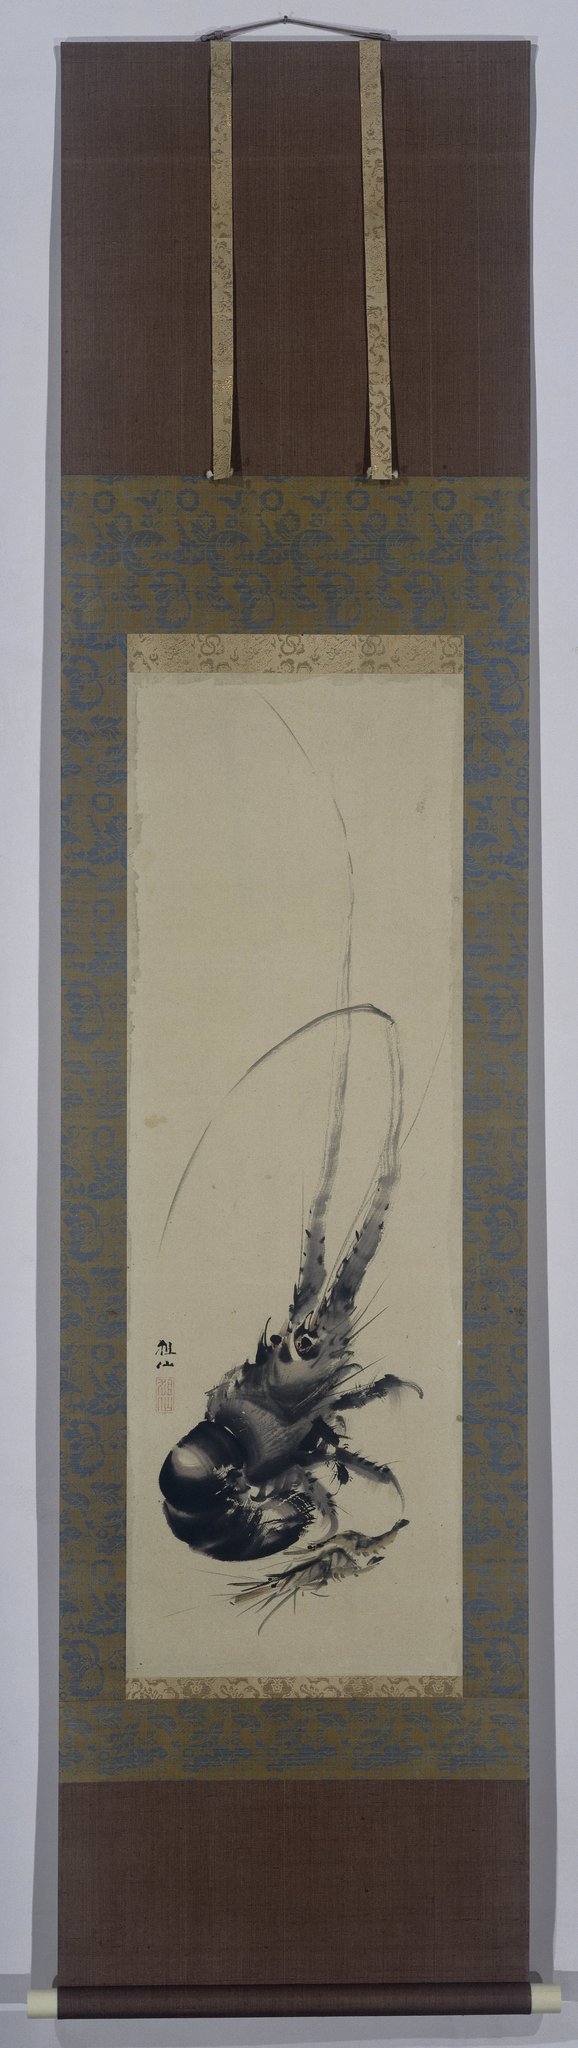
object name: hanging scroll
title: Langoustines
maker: mori sosen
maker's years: 1747-1821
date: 1800-1825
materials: ink, paper, silk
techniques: painted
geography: japan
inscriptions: seal: ‘Sosen’, signature: ‘Sosen’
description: Working from nature came first for Sosen. He made countless sketches to perfect his skills in rendering the animals as naturalistically as possible, both their appearance and their character. He depicted the langoustines with virtuoso strokes of ink, using subtle grey and black tones to beautifuly evoke the sheen and texture of the shells.